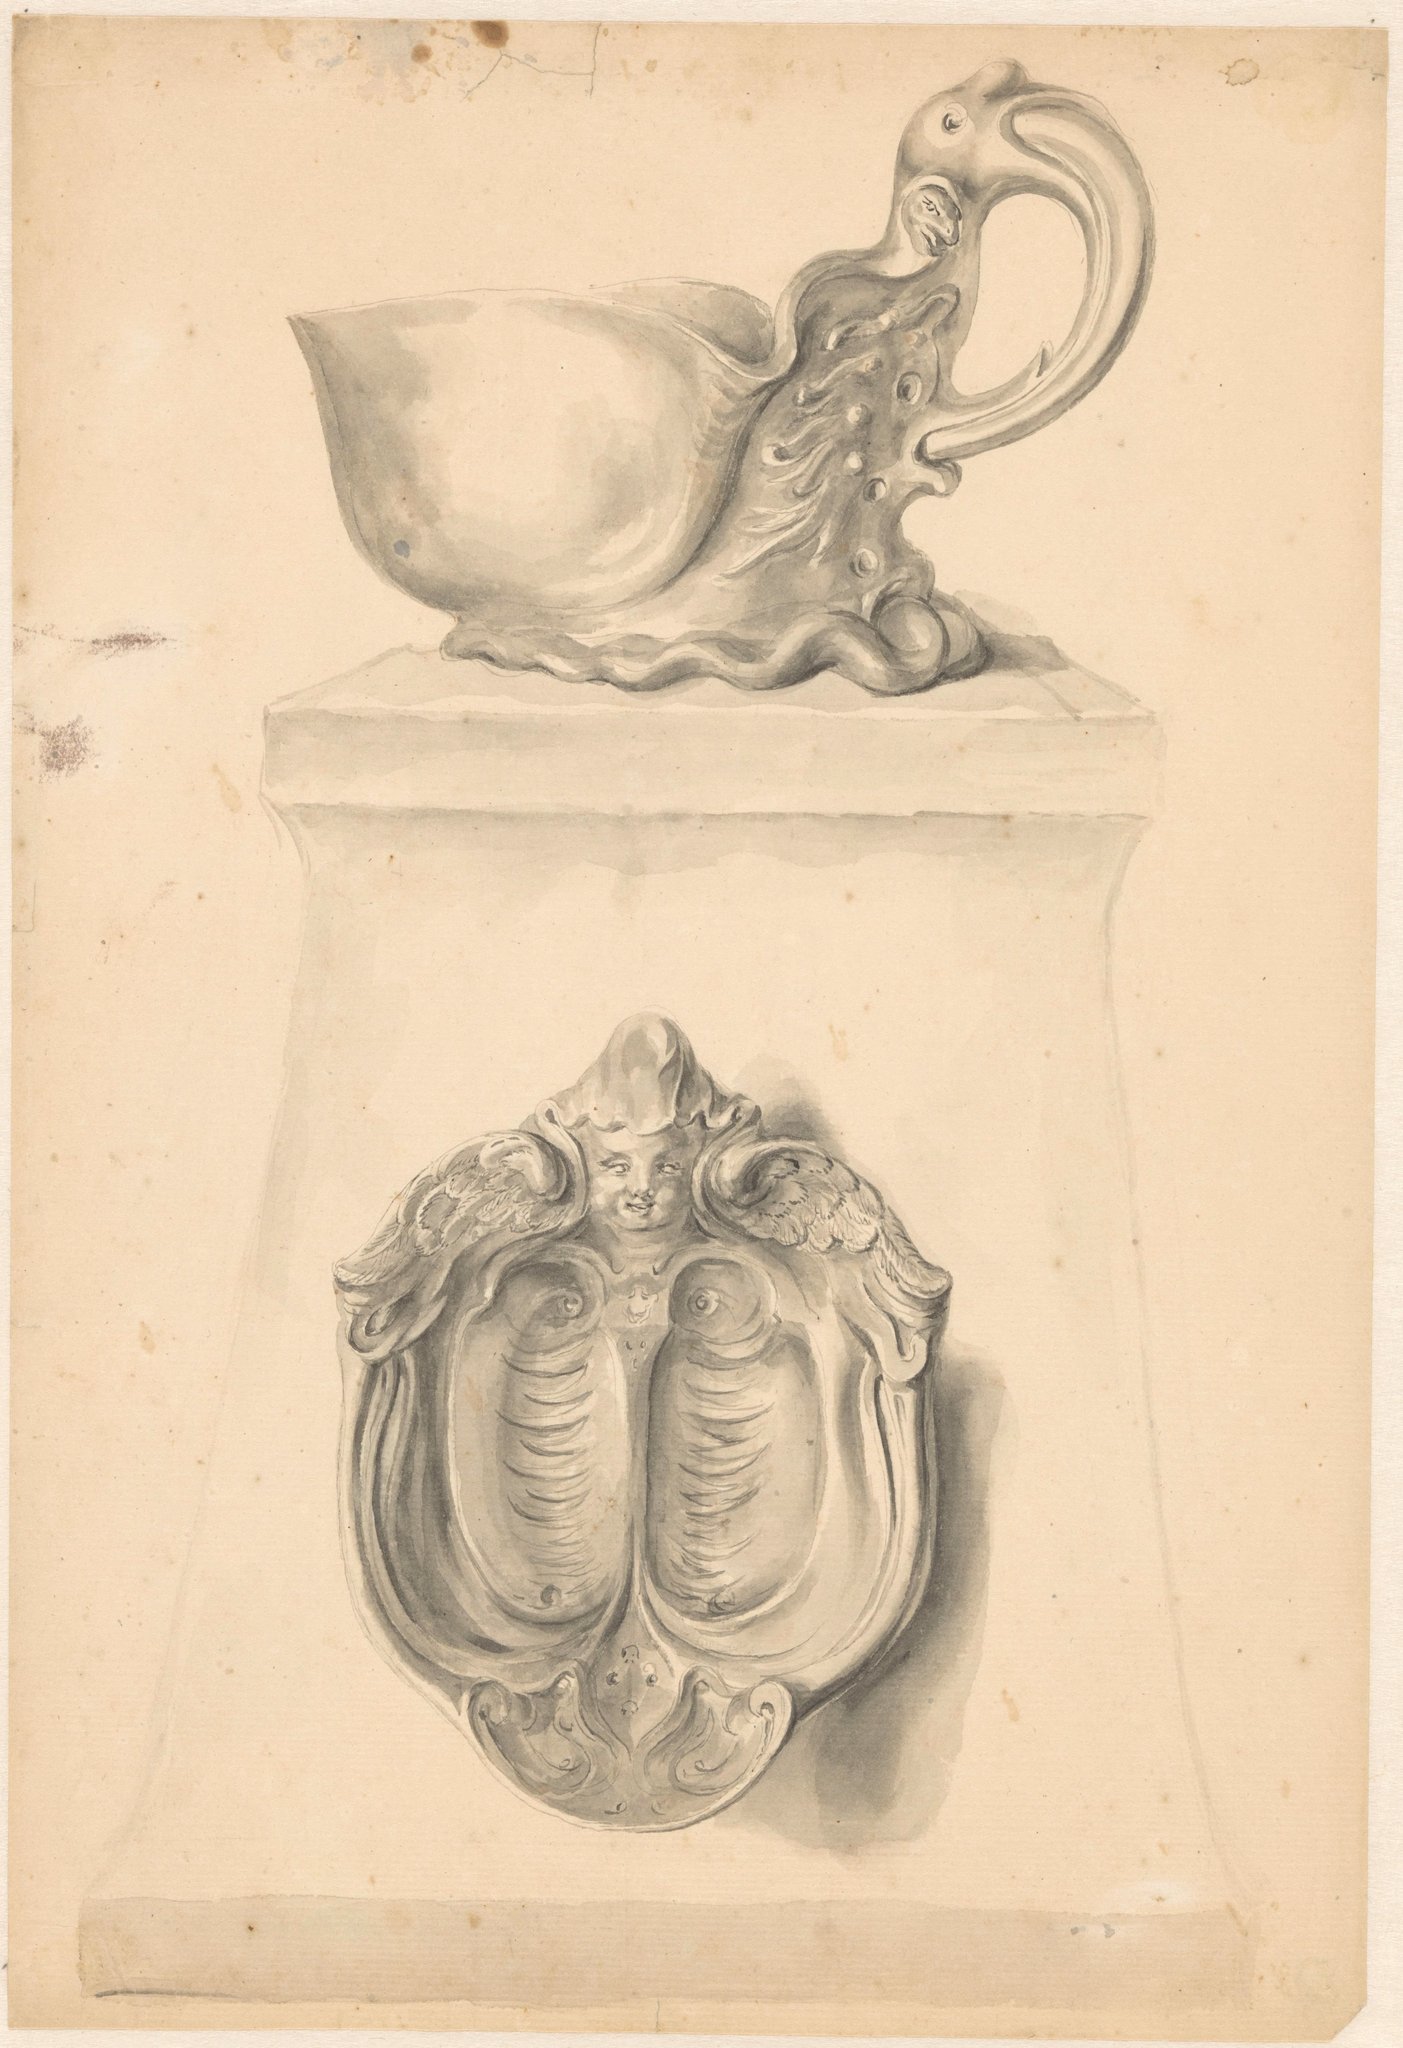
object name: album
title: Tekening van 17e eeuws zilver behorende bij een album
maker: Anonymous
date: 1725-1728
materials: paper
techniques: drawing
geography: amsterdam